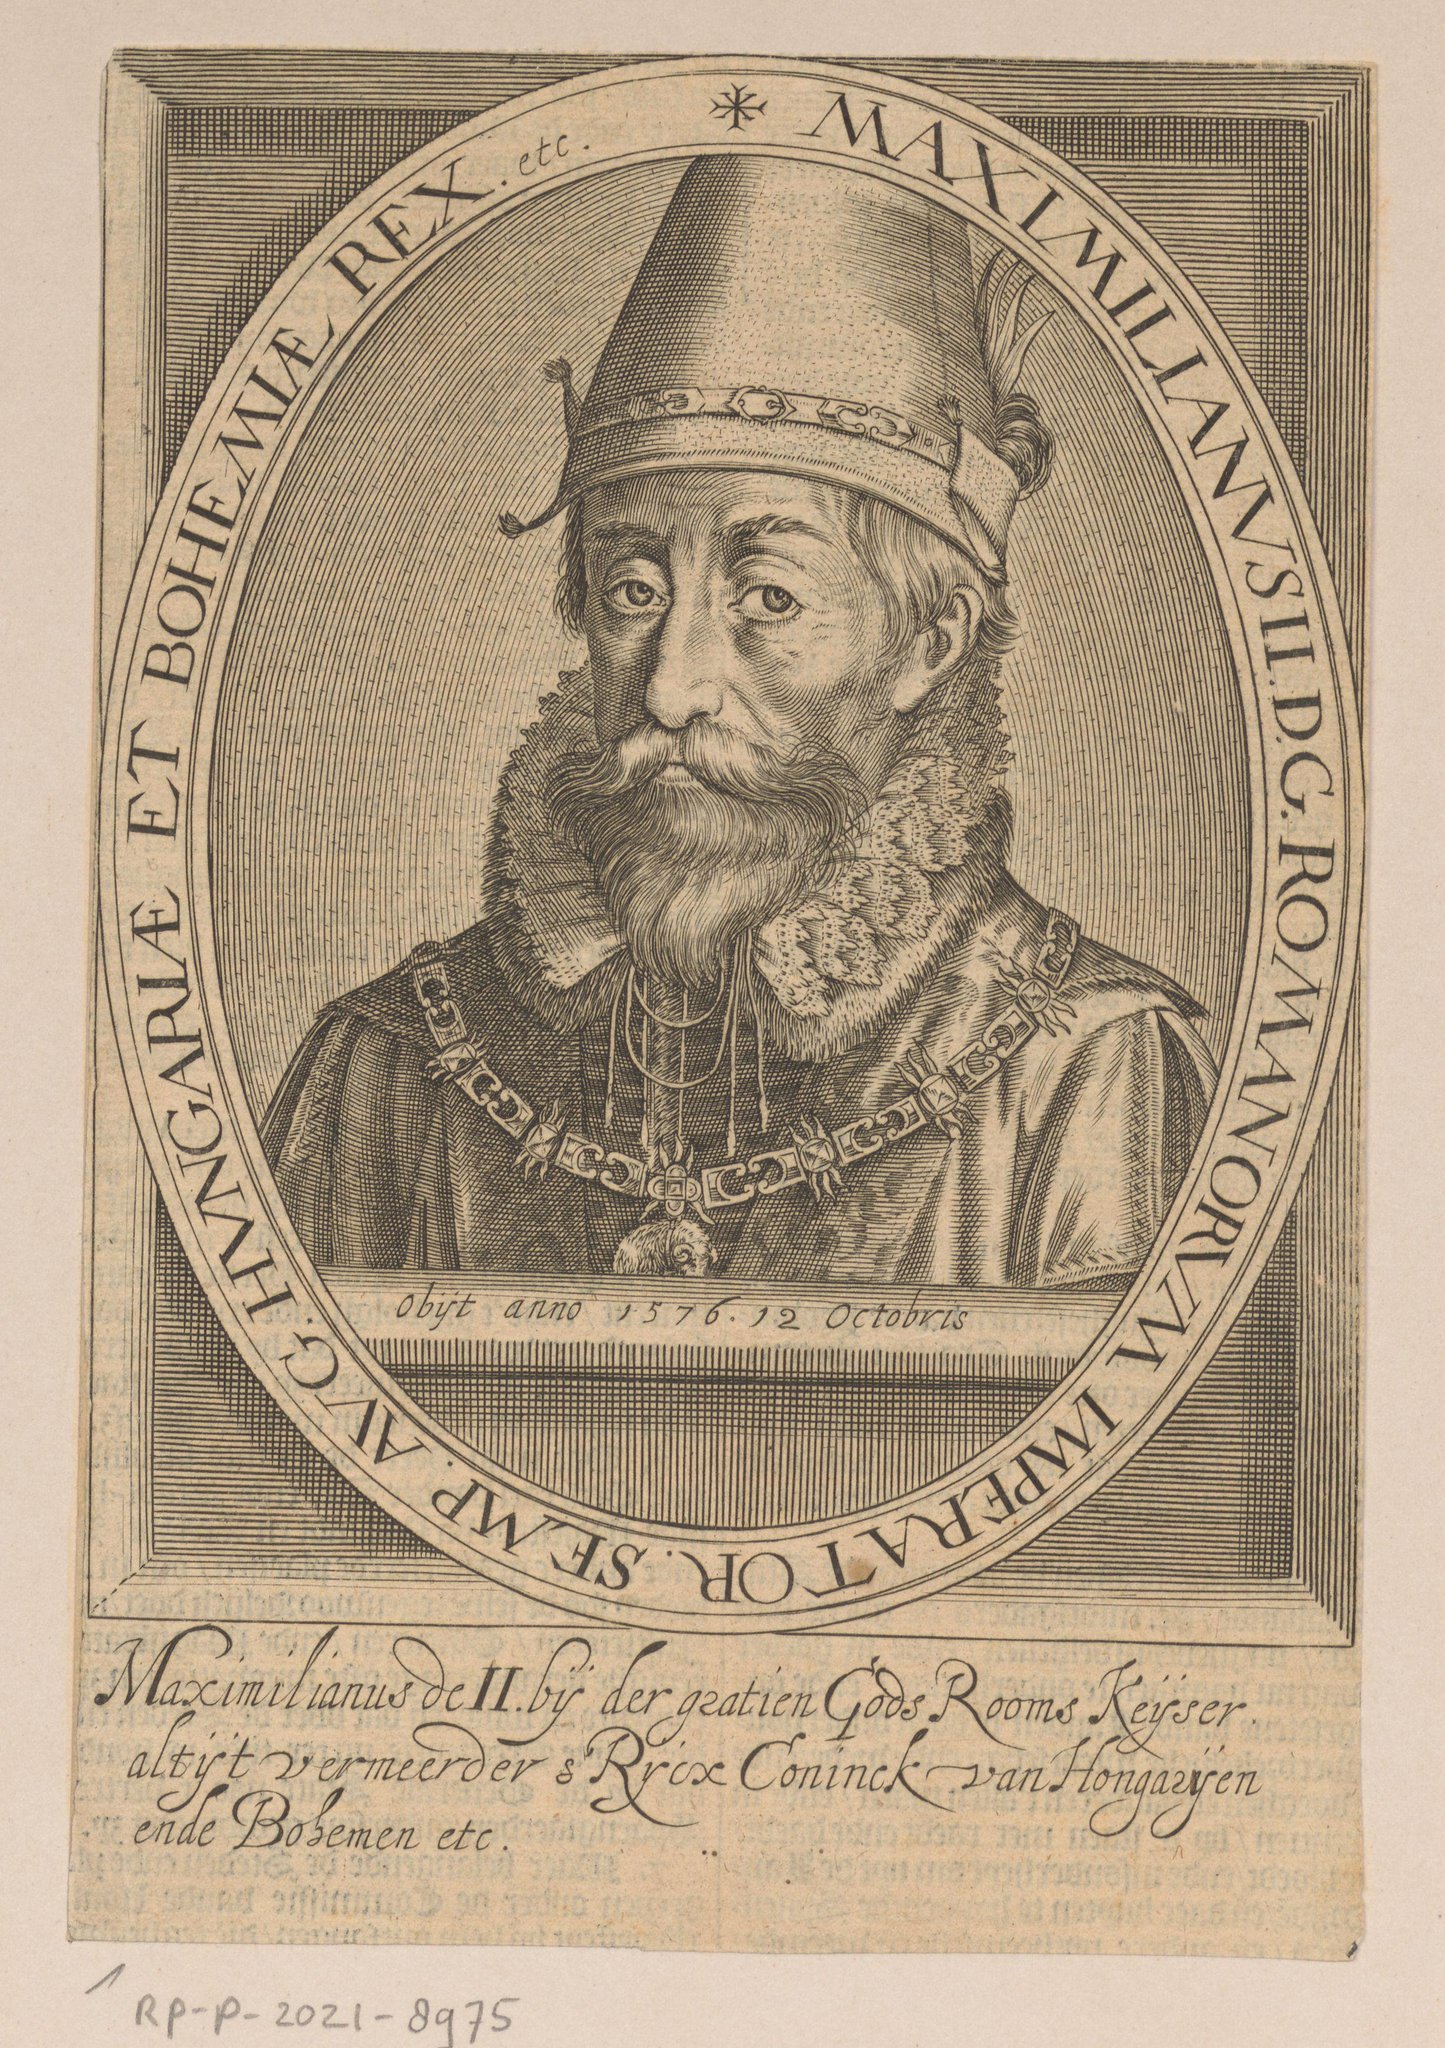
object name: print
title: Portret van keizer Maximiliaan II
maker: Anonymous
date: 1623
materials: paper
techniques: engraving, letterpress printing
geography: northern netherlands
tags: maximiliaan ii (keizer van heilige roomse rijk), ornament ~ medallion, historical persons, knighthood order of the golden fleece - insignia of a knighthood order, e.g.: badge, chain (with name of order)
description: Prent met dezelfde tekst op verso, maar in een andere druk, gebruikt in: Meteren, Emanuel van. Historie der Nederlandscher ende haerder Na-buren Oorlogen ende geschiedenissen (...). Den Haag: weduwe Hillebrant Jacobsz. van Wouw, 1623.